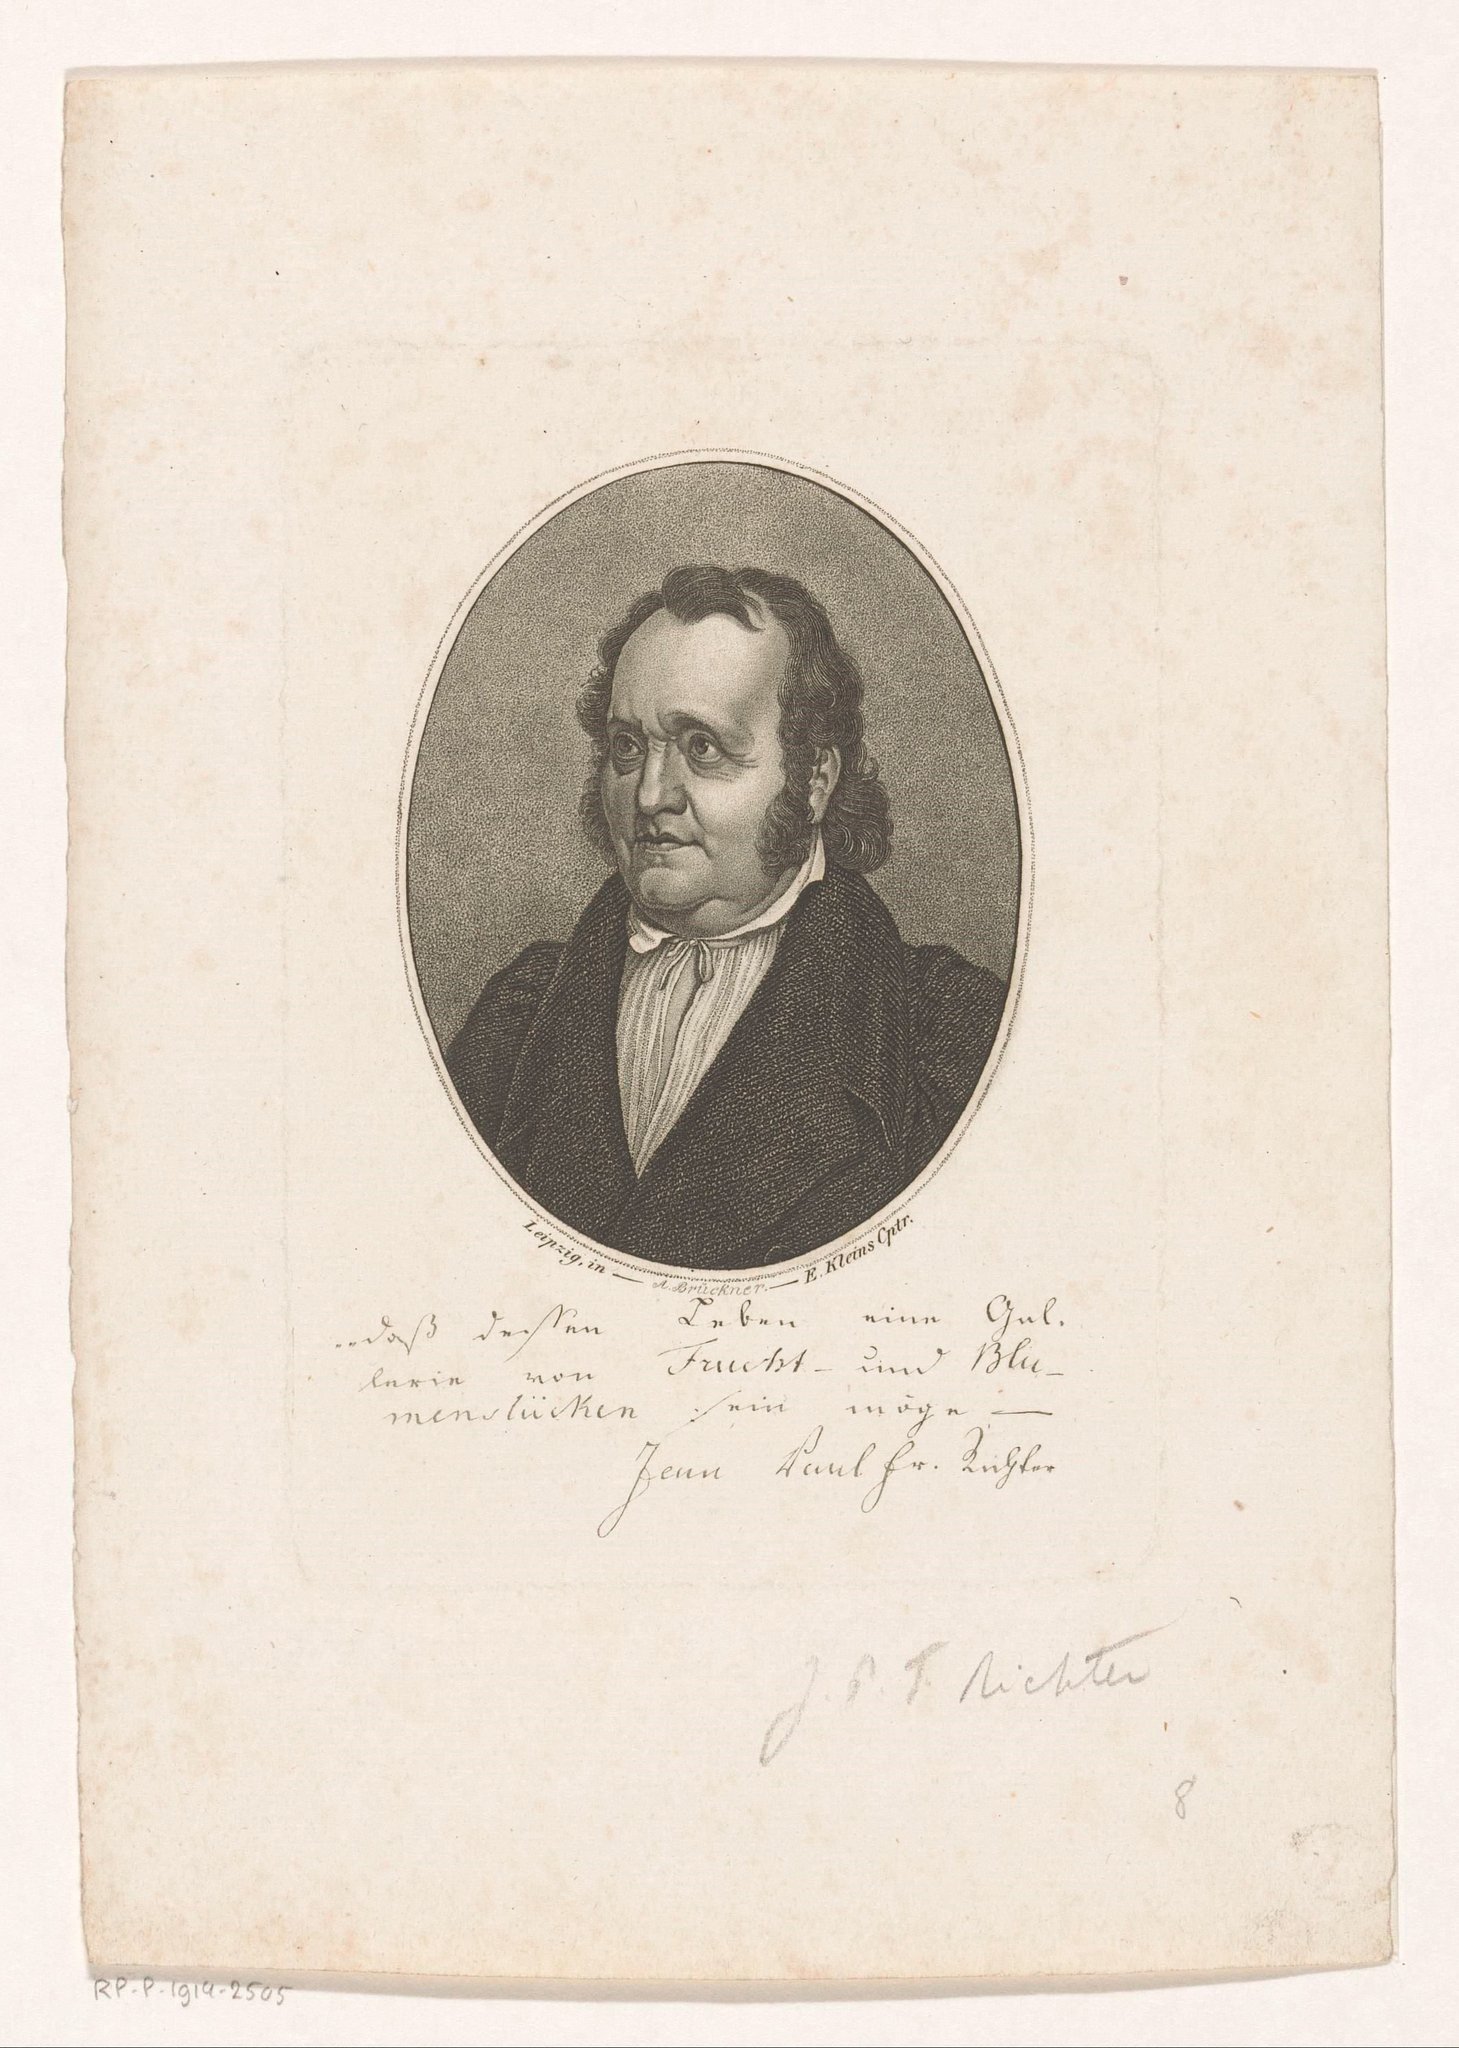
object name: print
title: Portret van Jean Paul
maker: friedrich august brückner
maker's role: print maker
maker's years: 1785-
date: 1795-1895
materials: paper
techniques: stippling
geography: leipzig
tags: jean paul, historical persons, portrait of a writer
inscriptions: collector's mark: Lugt 2228, inscription: ‘dass deinen Leben eine Gal- / lerie von Frucht- und Blu- / menstücken sein mögen / Jean Paul Fr. Richter’